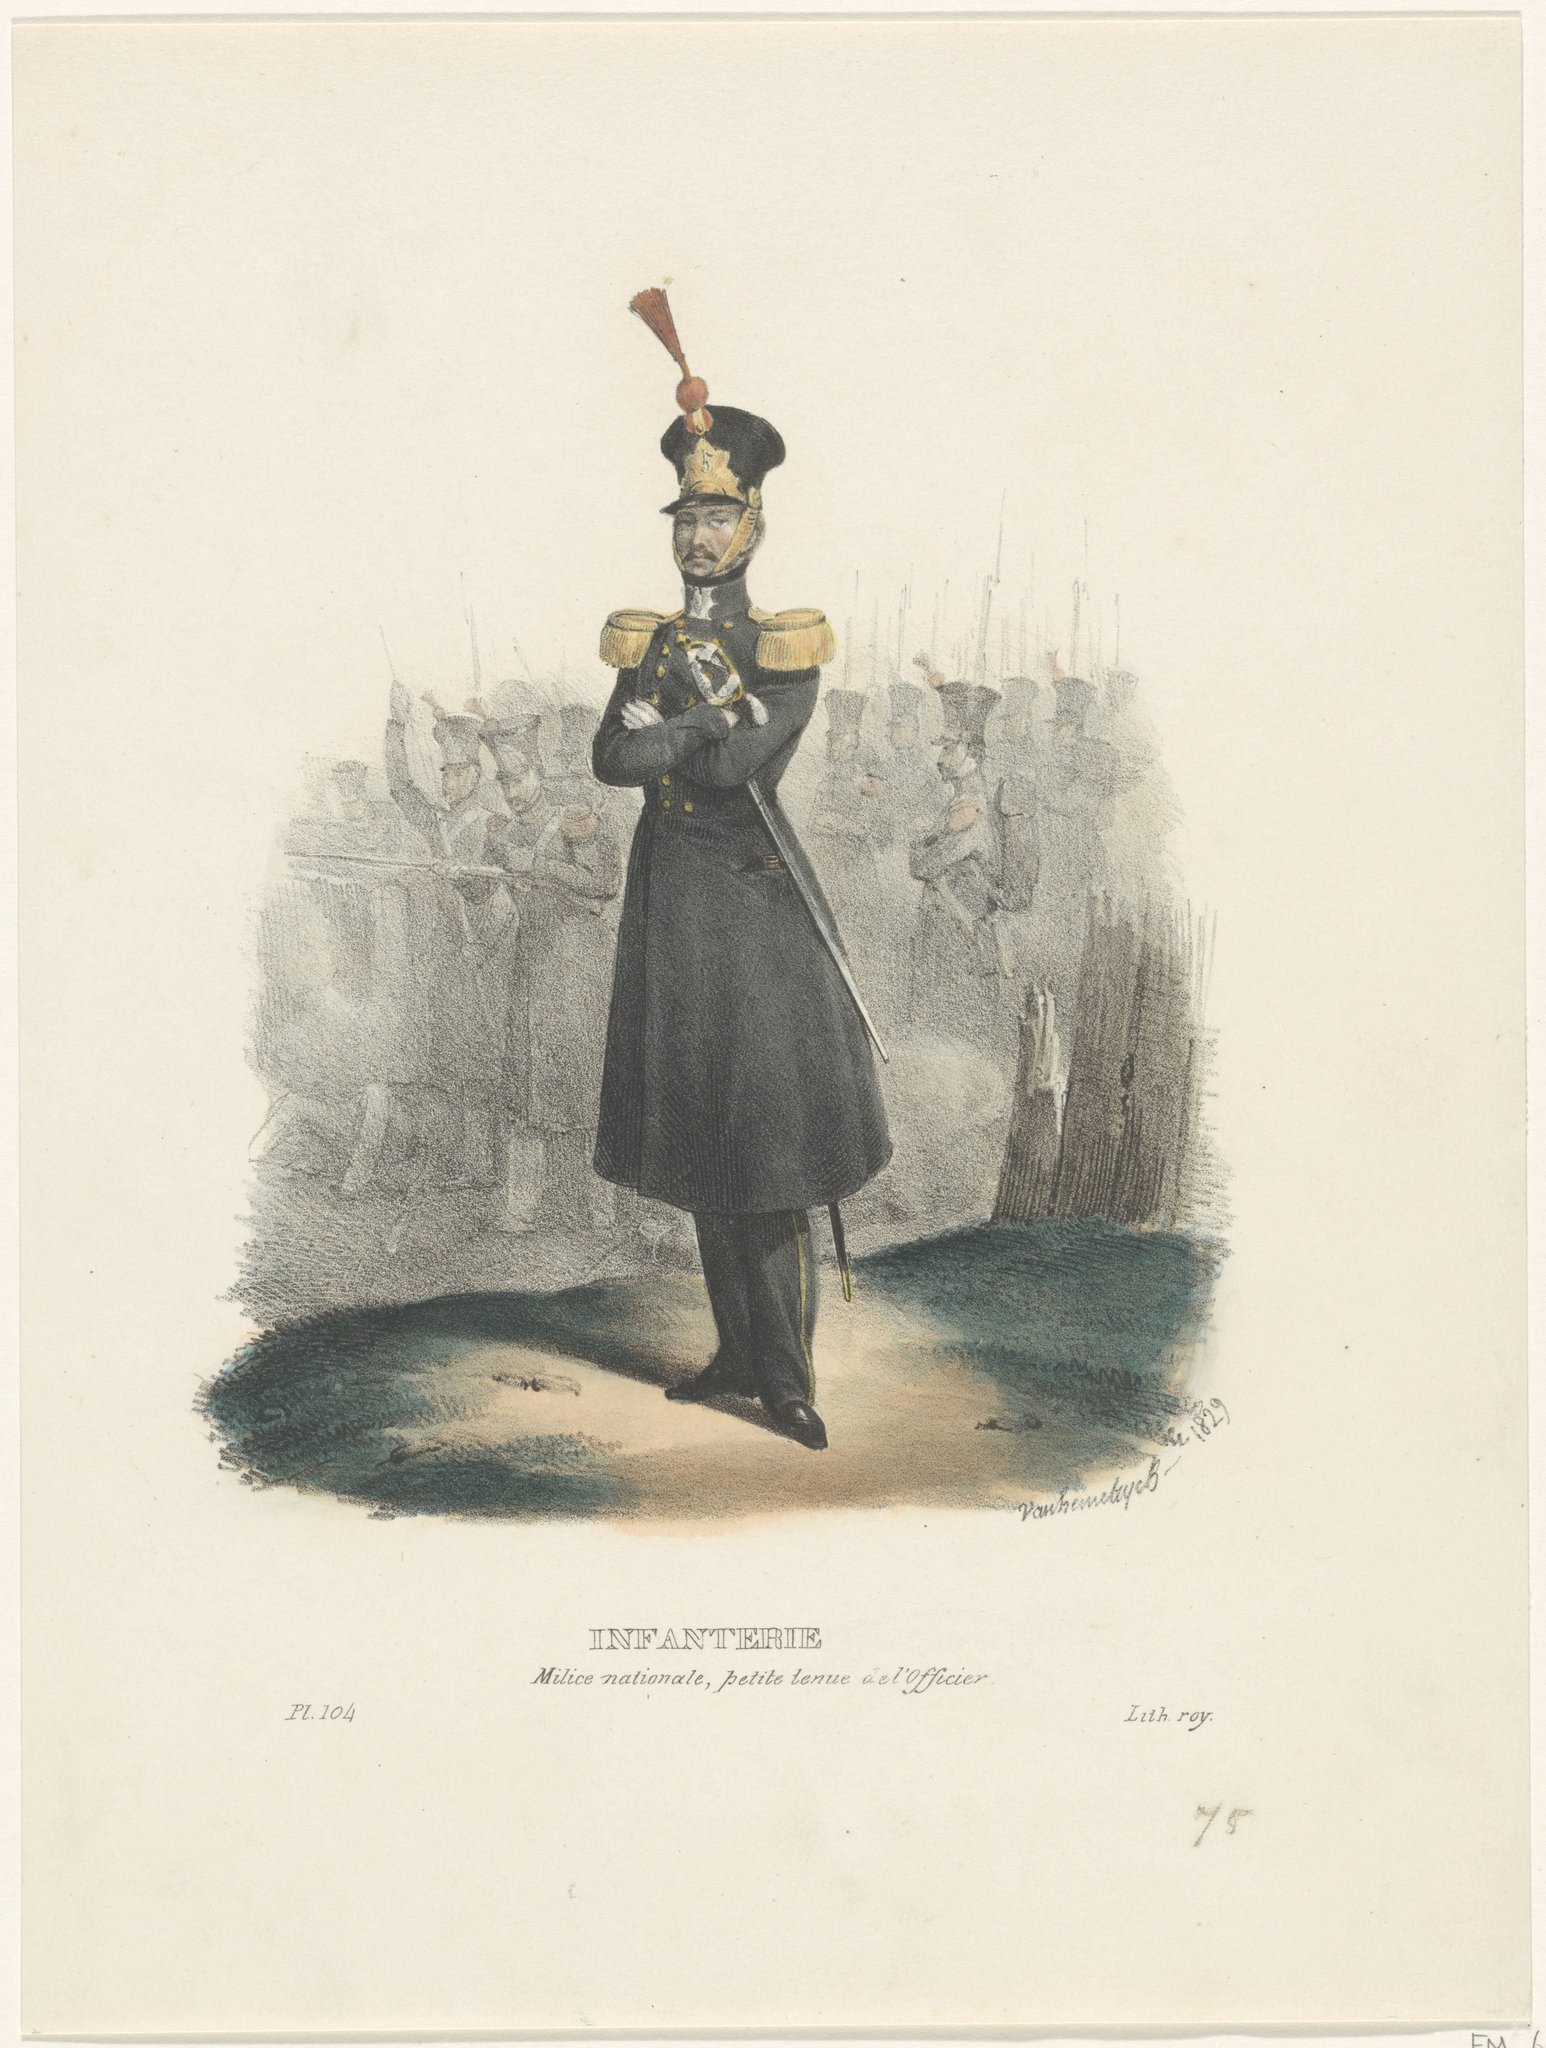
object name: costume print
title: Officier van de Nationale Militie, 1829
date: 1829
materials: paper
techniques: hand coloring, lithograph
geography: brussels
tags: (military) uniforms, clothes, costume, belgium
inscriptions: collector's mark: Lugt 2228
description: Een officier van de infanterie van de Belgische Nationale Militie, staande met de armen over elkaar, 1829. Genummerd linksonder: Pl. 104. Onderdeel van een groep voorstellingen van Belgische uniformen.